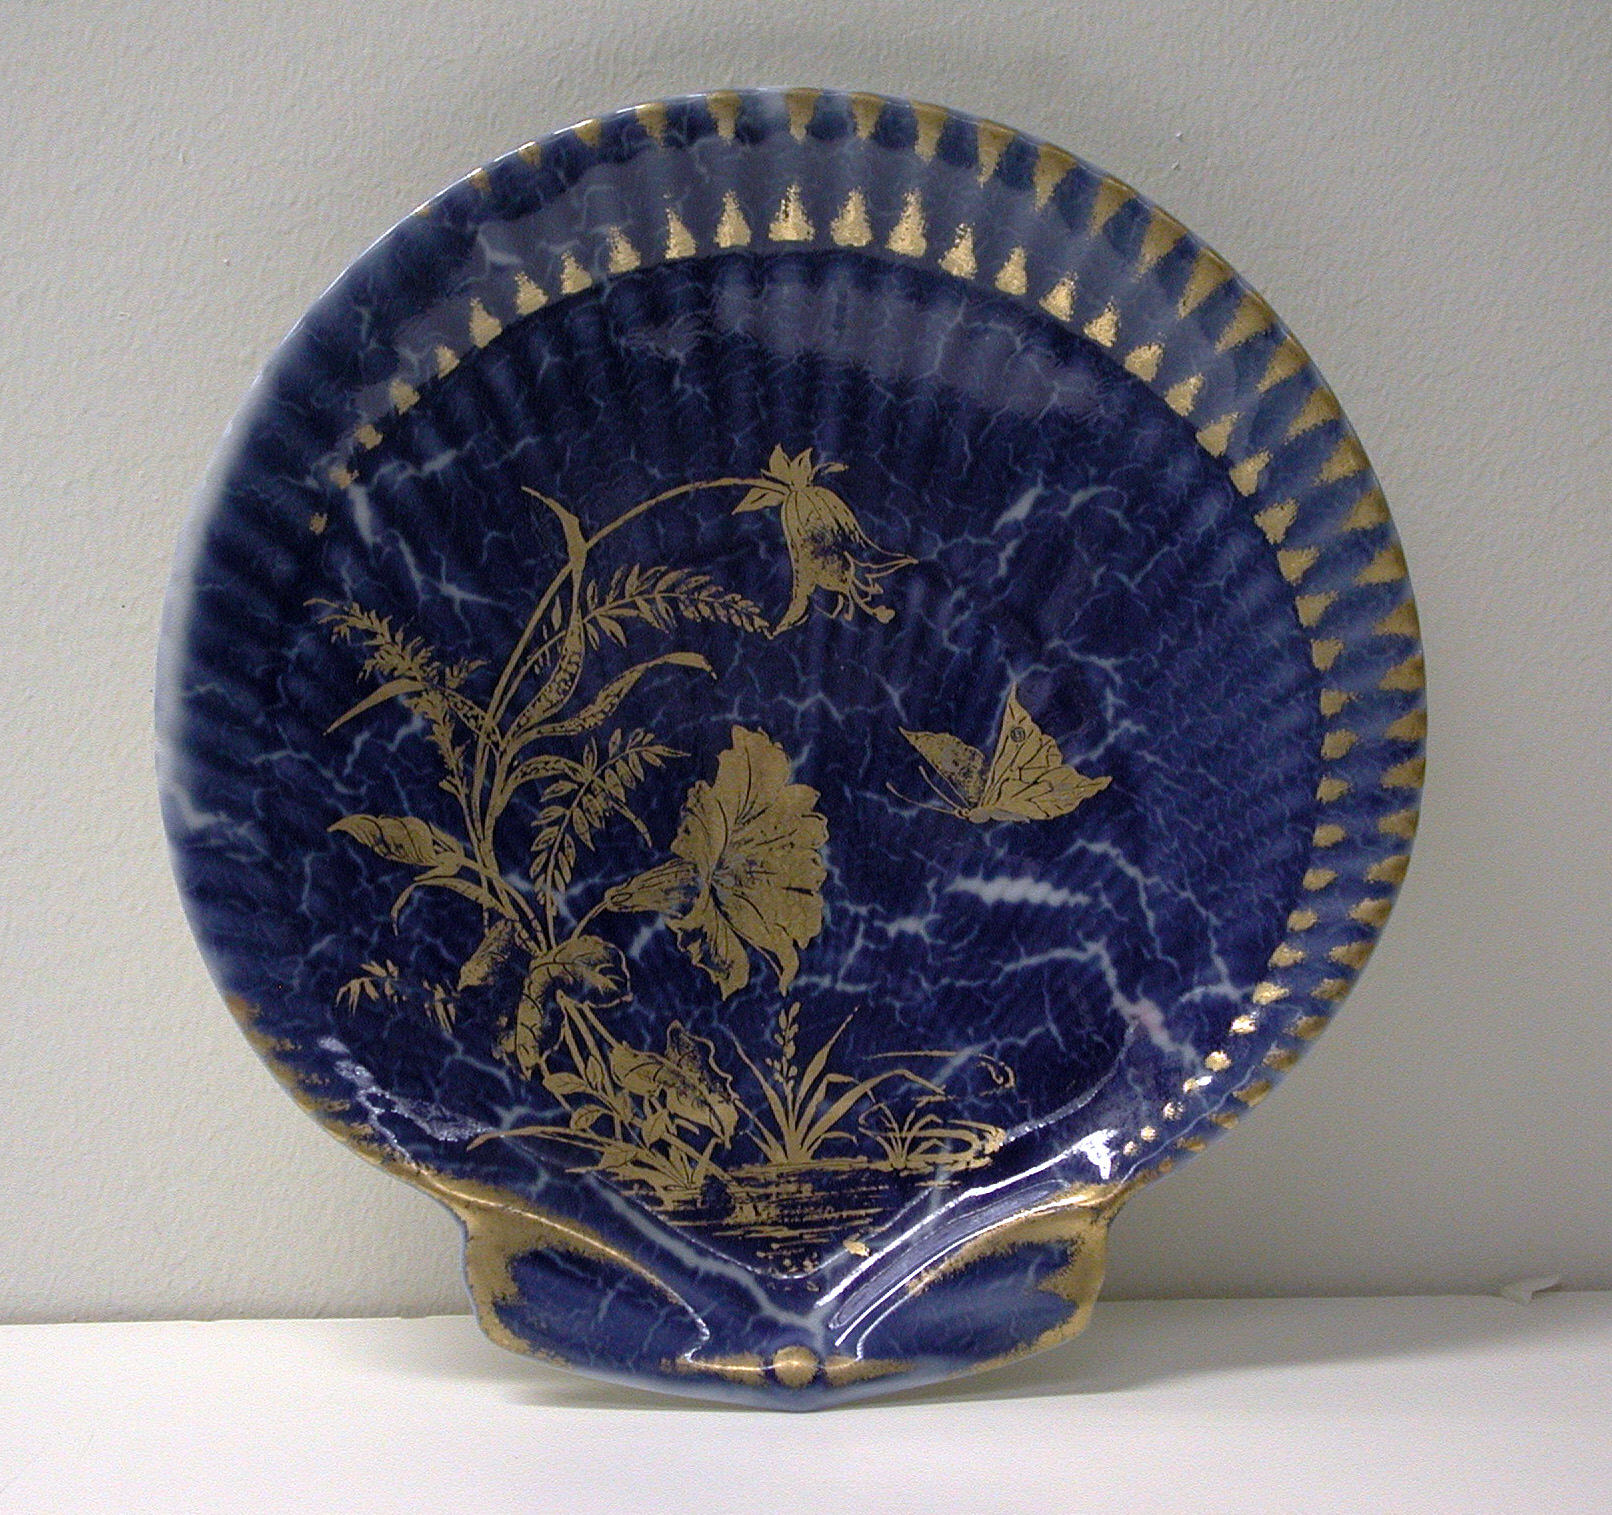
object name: dish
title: Pair of dishes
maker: royal porcelain manufactory, berlin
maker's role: manufactory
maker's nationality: german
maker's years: 1763-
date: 1880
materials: gilt, hard paste porcelain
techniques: enamel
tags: butterflies,flowers